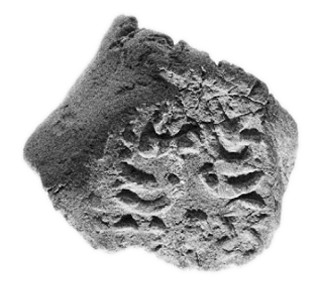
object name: sealing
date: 1981-1640 BCE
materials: mud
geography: egypt